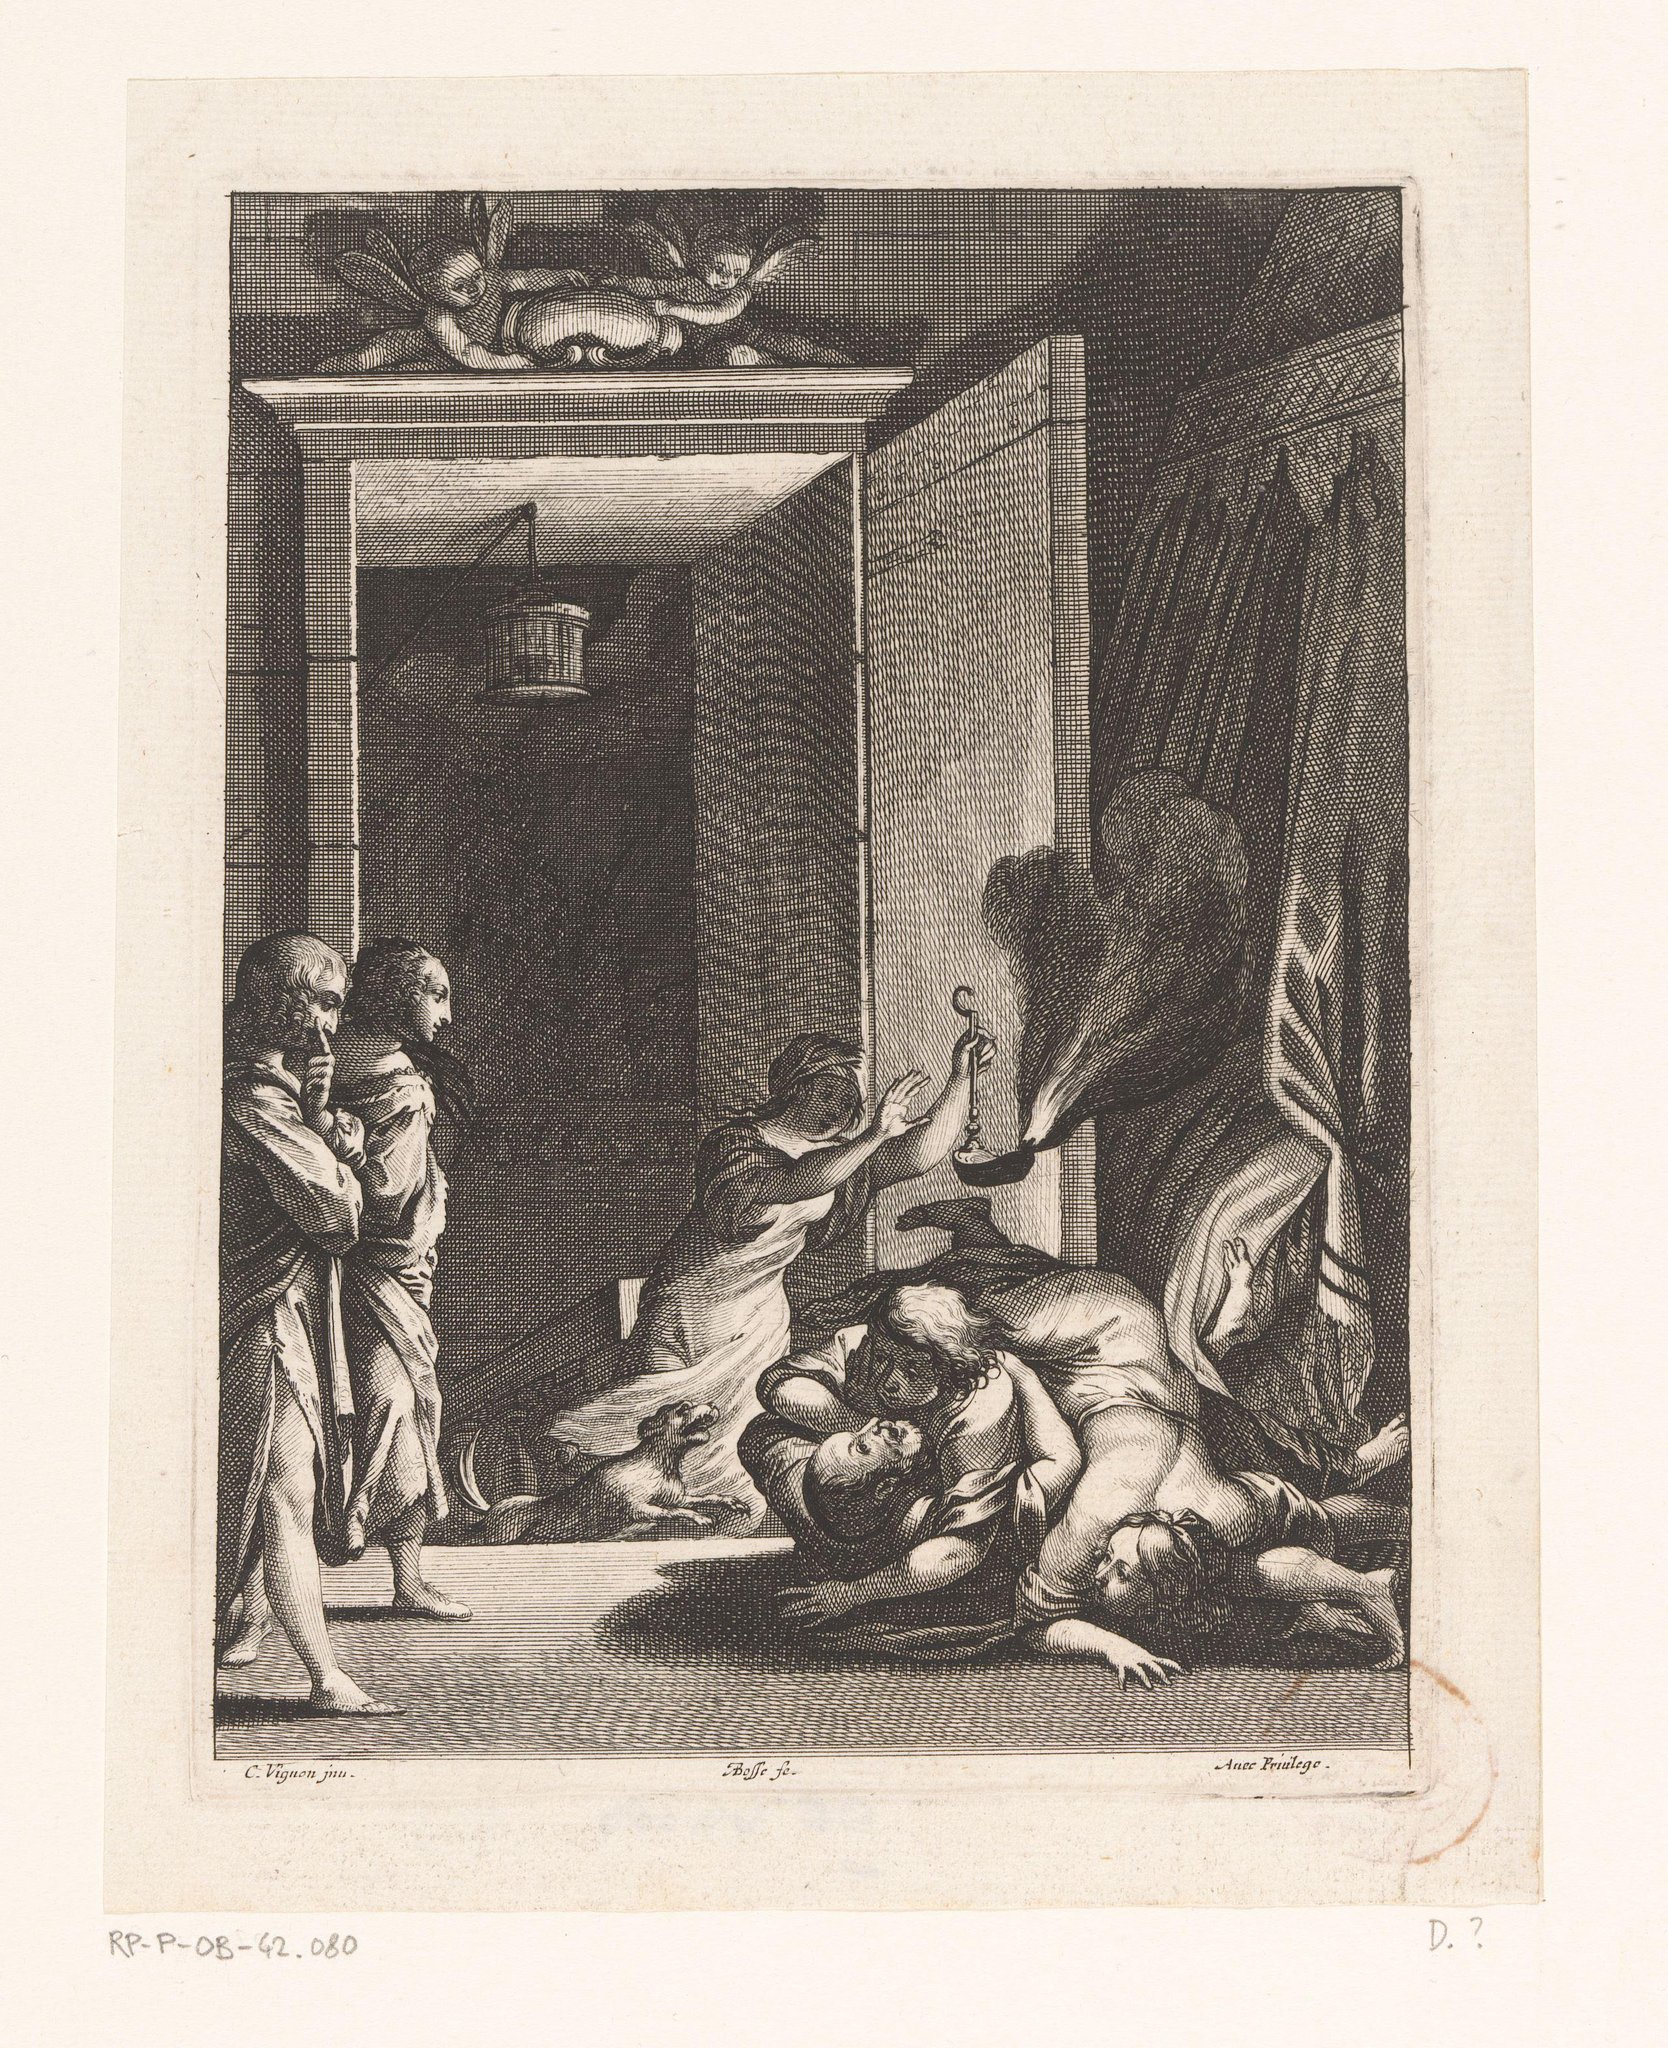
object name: book illustration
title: Mélinte en Eurylas vinden de gevallen Corinne, Curion en Palamède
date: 1639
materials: paper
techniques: engraving, etching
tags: circumstance, accident, nursing, tending the sick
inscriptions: collector's mark: Lugt 240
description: Prent uit: Desmarets de Saint-Sorlin, Jean. L'Ariane. Parijs: Guillemot, Matthieu, 1639.